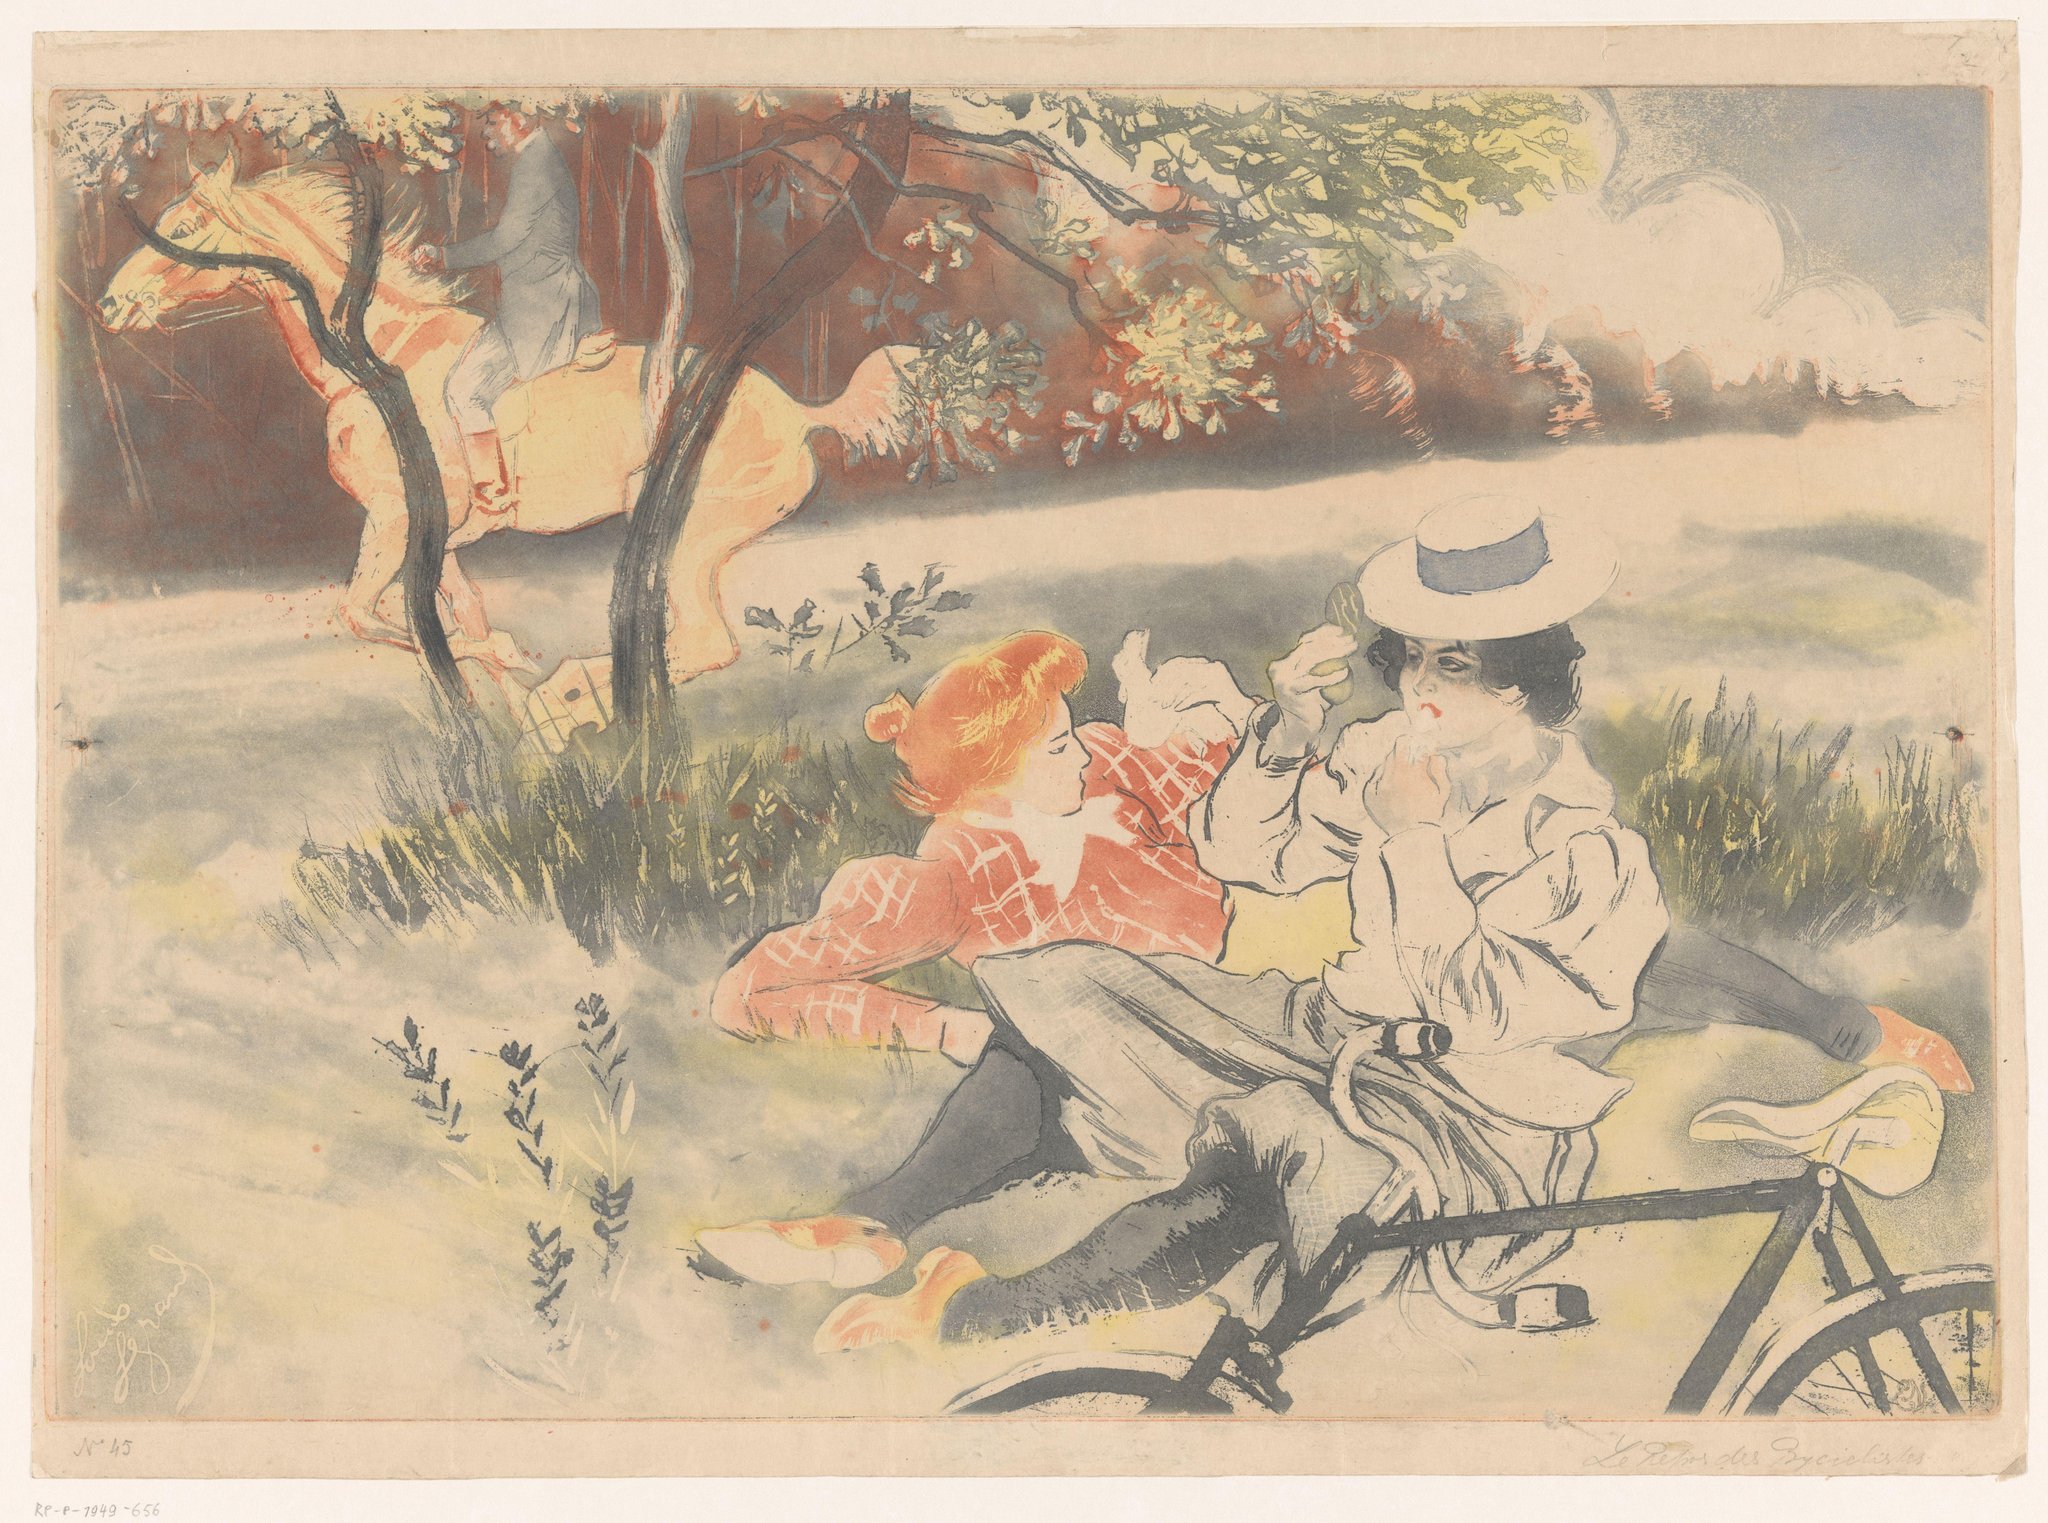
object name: print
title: Le Retour des Byciclistes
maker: louis legrand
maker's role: painter, print maker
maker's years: 1863-1951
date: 1873-1949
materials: paper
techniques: etching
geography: france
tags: riding a horse, ass, or mule; rider, horseman, bicycle, resting - bb - out of doors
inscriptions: collector's mark: Lugt 2228, collector's mark: Lugt 2760